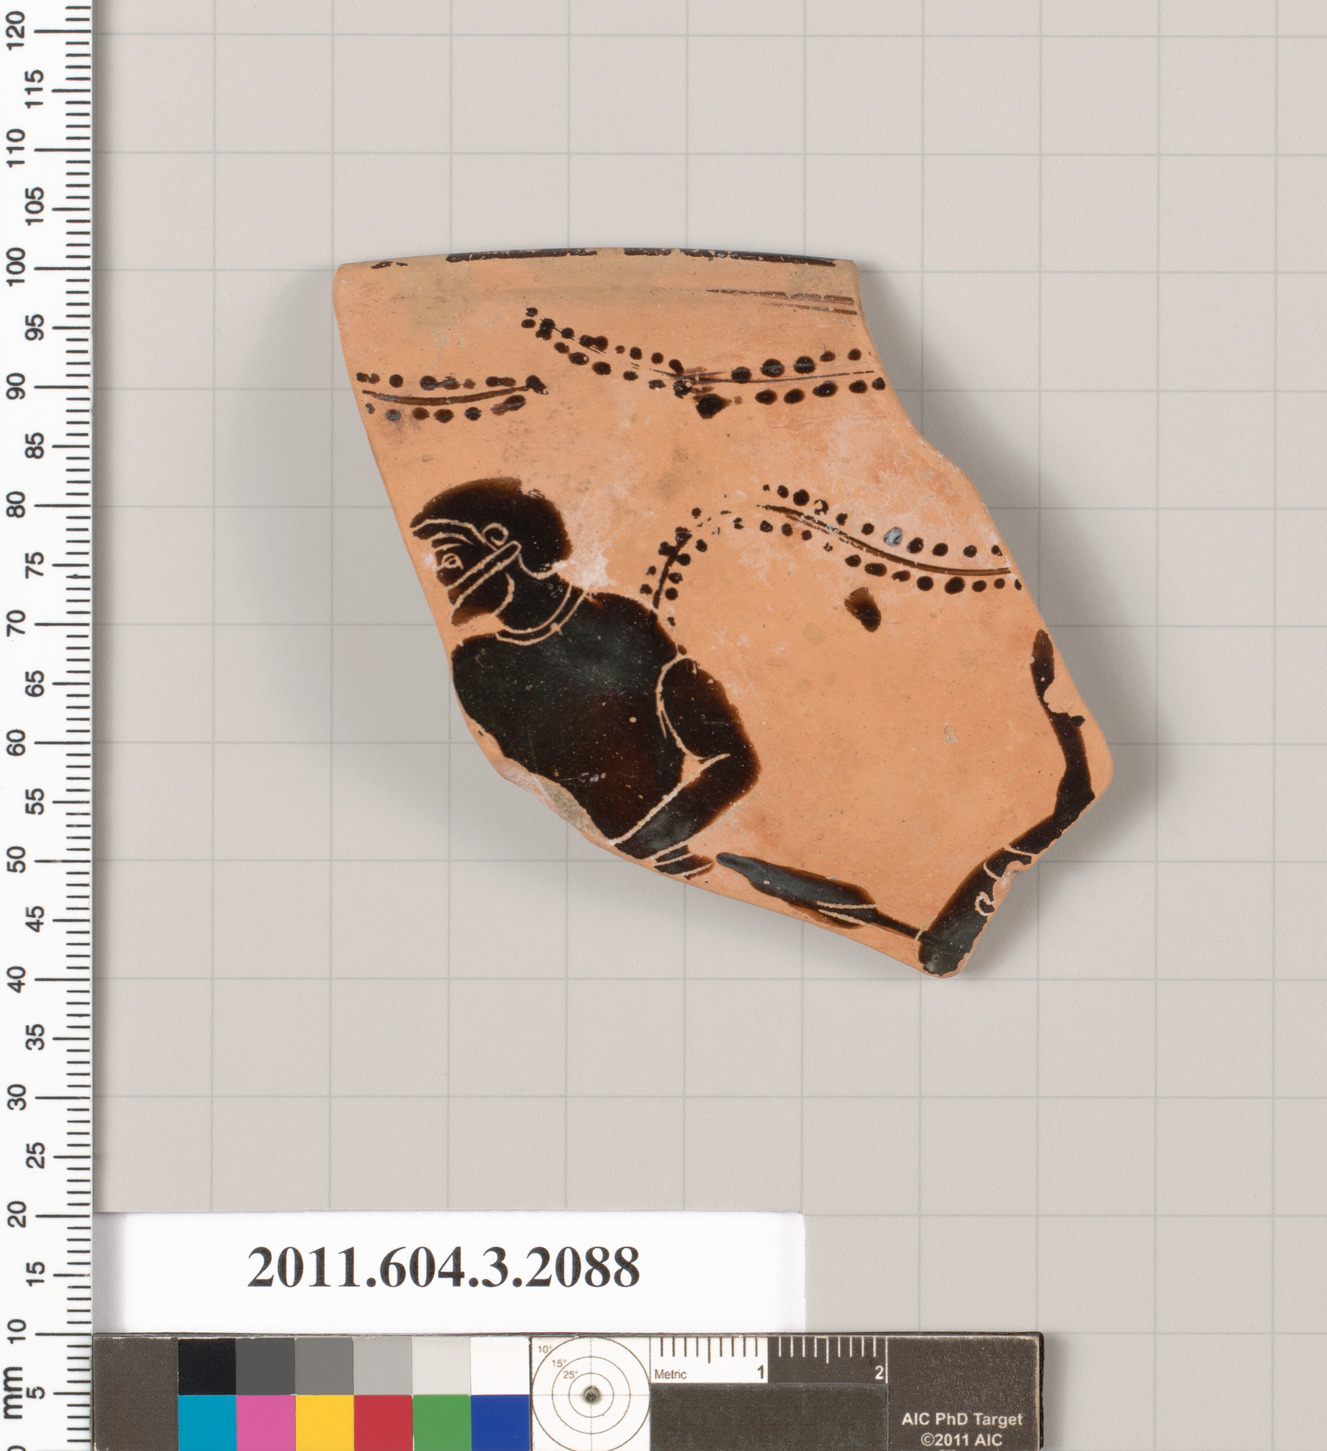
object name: kylix fragment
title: Terracotta rim fragment of a kylix (drinking cup)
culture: greek, attic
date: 534-501 BCE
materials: terracotta